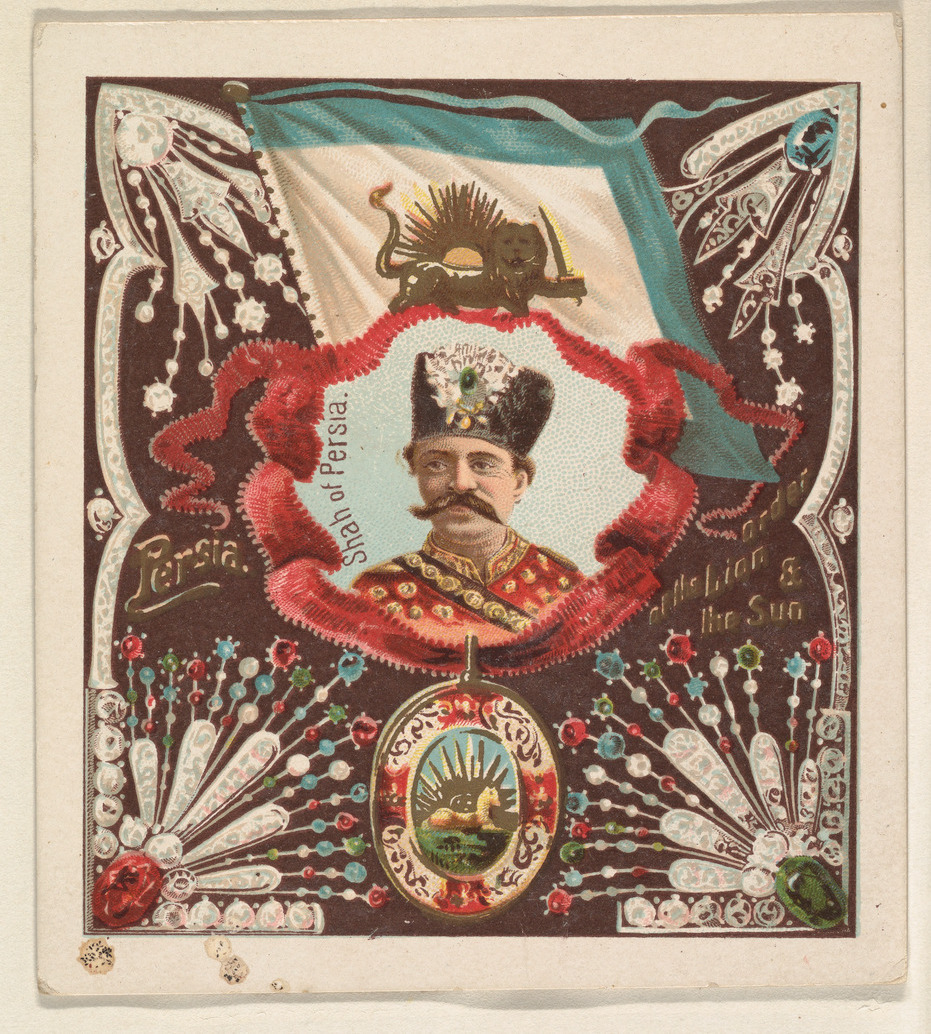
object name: print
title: Persia, from the International Cards series (N238), issued by Kinney Bros.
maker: kinney brothers tobacco company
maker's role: publisher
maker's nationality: american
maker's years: 1869-2011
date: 1888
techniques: color lithograph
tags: men,flags